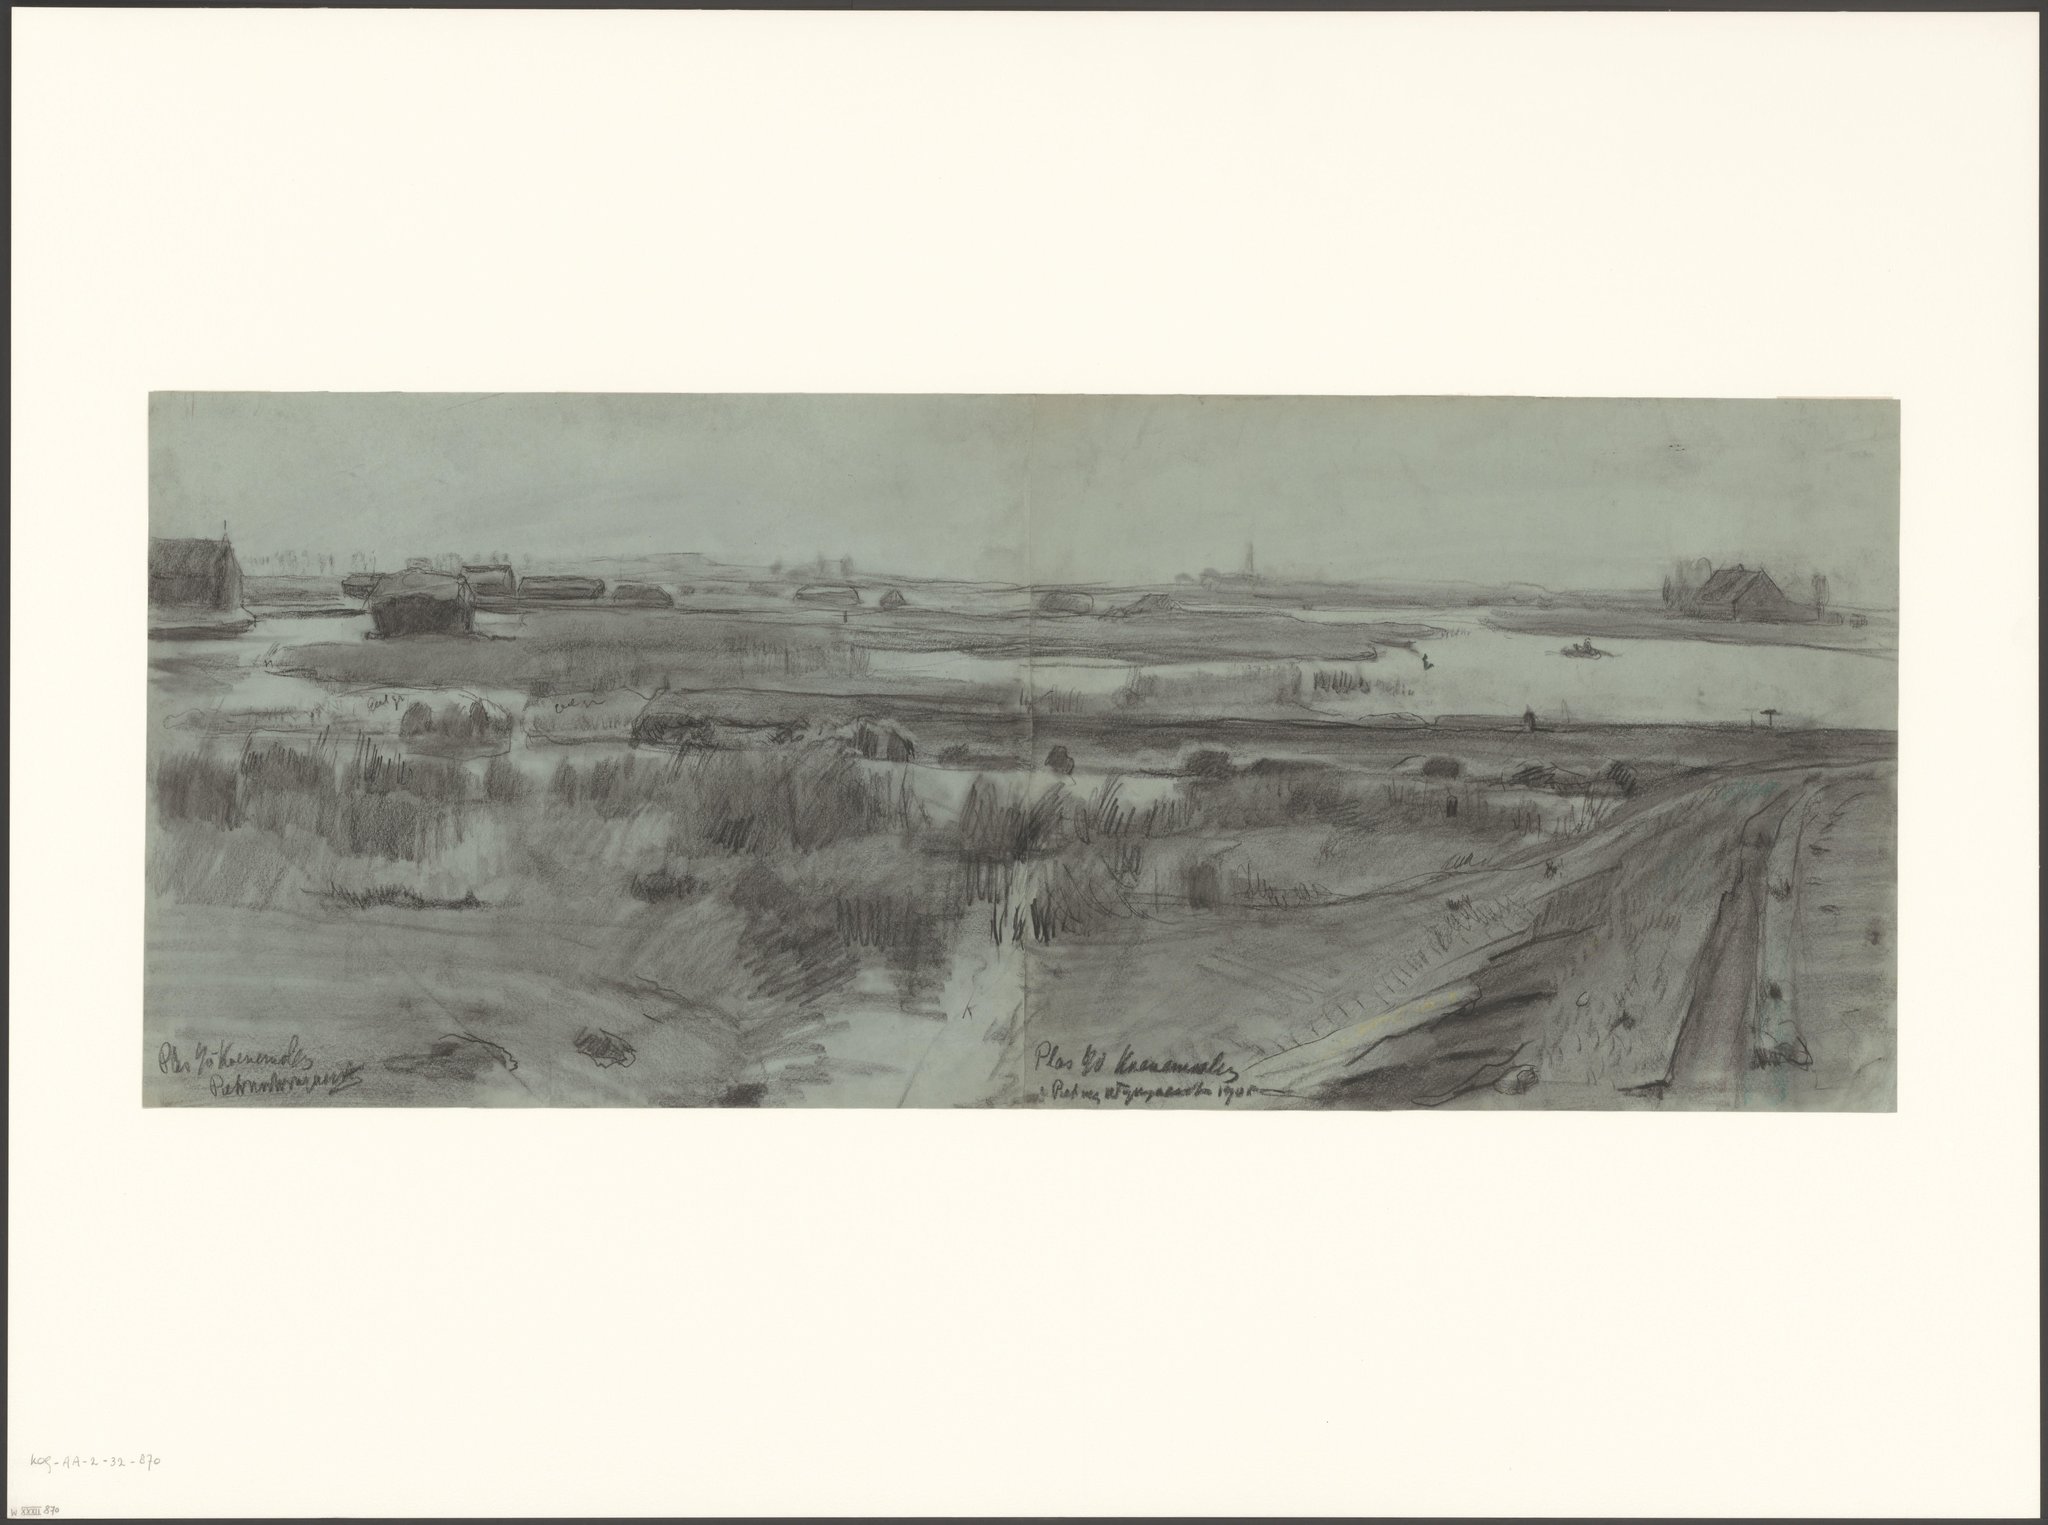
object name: drawing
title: Gezicht op de Buitendijkse Buitenvelderse polder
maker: piet van wijngaerdt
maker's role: draughtsman, print maker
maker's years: 1873-1964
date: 1901-1909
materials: chalk, paper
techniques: pasting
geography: amsterdam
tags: city-view in general; 'veduta', pond, pool, polder, reclaimed land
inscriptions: inscription: ‘Plas b/d Koenenmolen’, signature and date: ‘PietvanWijngaerdt 190[...]’, collector's mark: Lugt 800a, signature: ‘Pietvanwijngaerdt’, inscription: ‘Buitendyksche Buiten veldersche (...) kerktoren / van Bovenkerk.’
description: Tekening binnen de Atlas Van Eck ingedeeld op wijknummer 32.